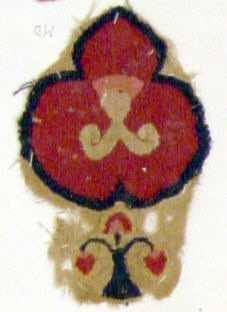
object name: textile fragment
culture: coptic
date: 401-500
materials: linen, wool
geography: egypt